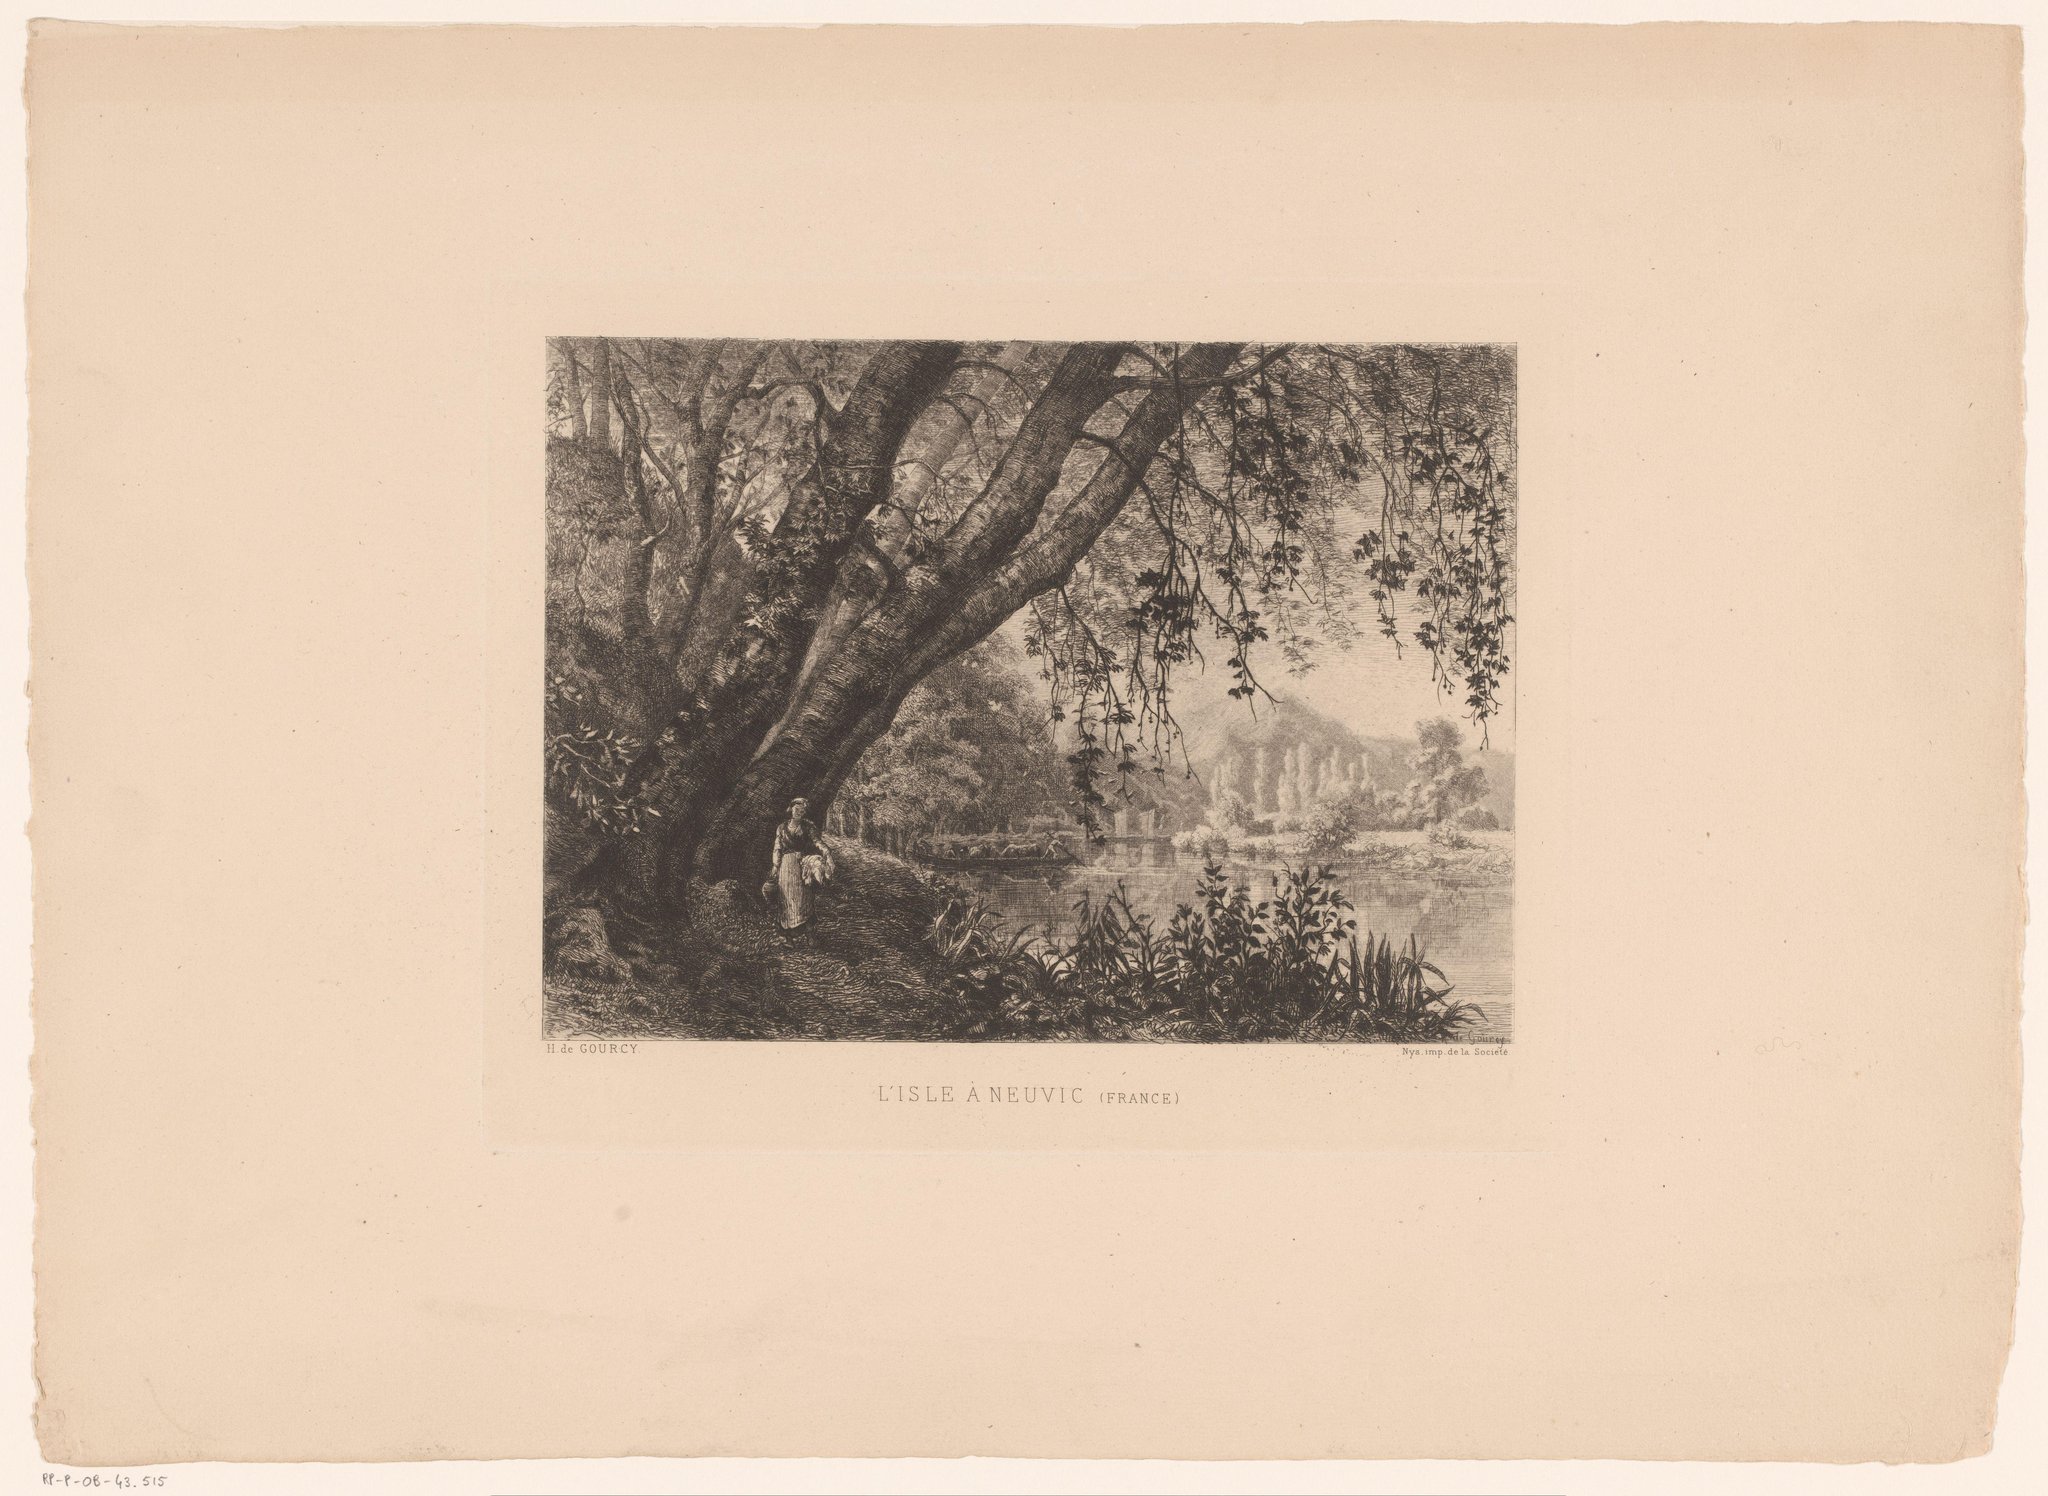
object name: print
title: Gezicht op een eiland te Neuvic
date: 1867-1878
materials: paper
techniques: drypoint, etching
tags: island, ferry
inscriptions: collector's mark: Lugt 2228